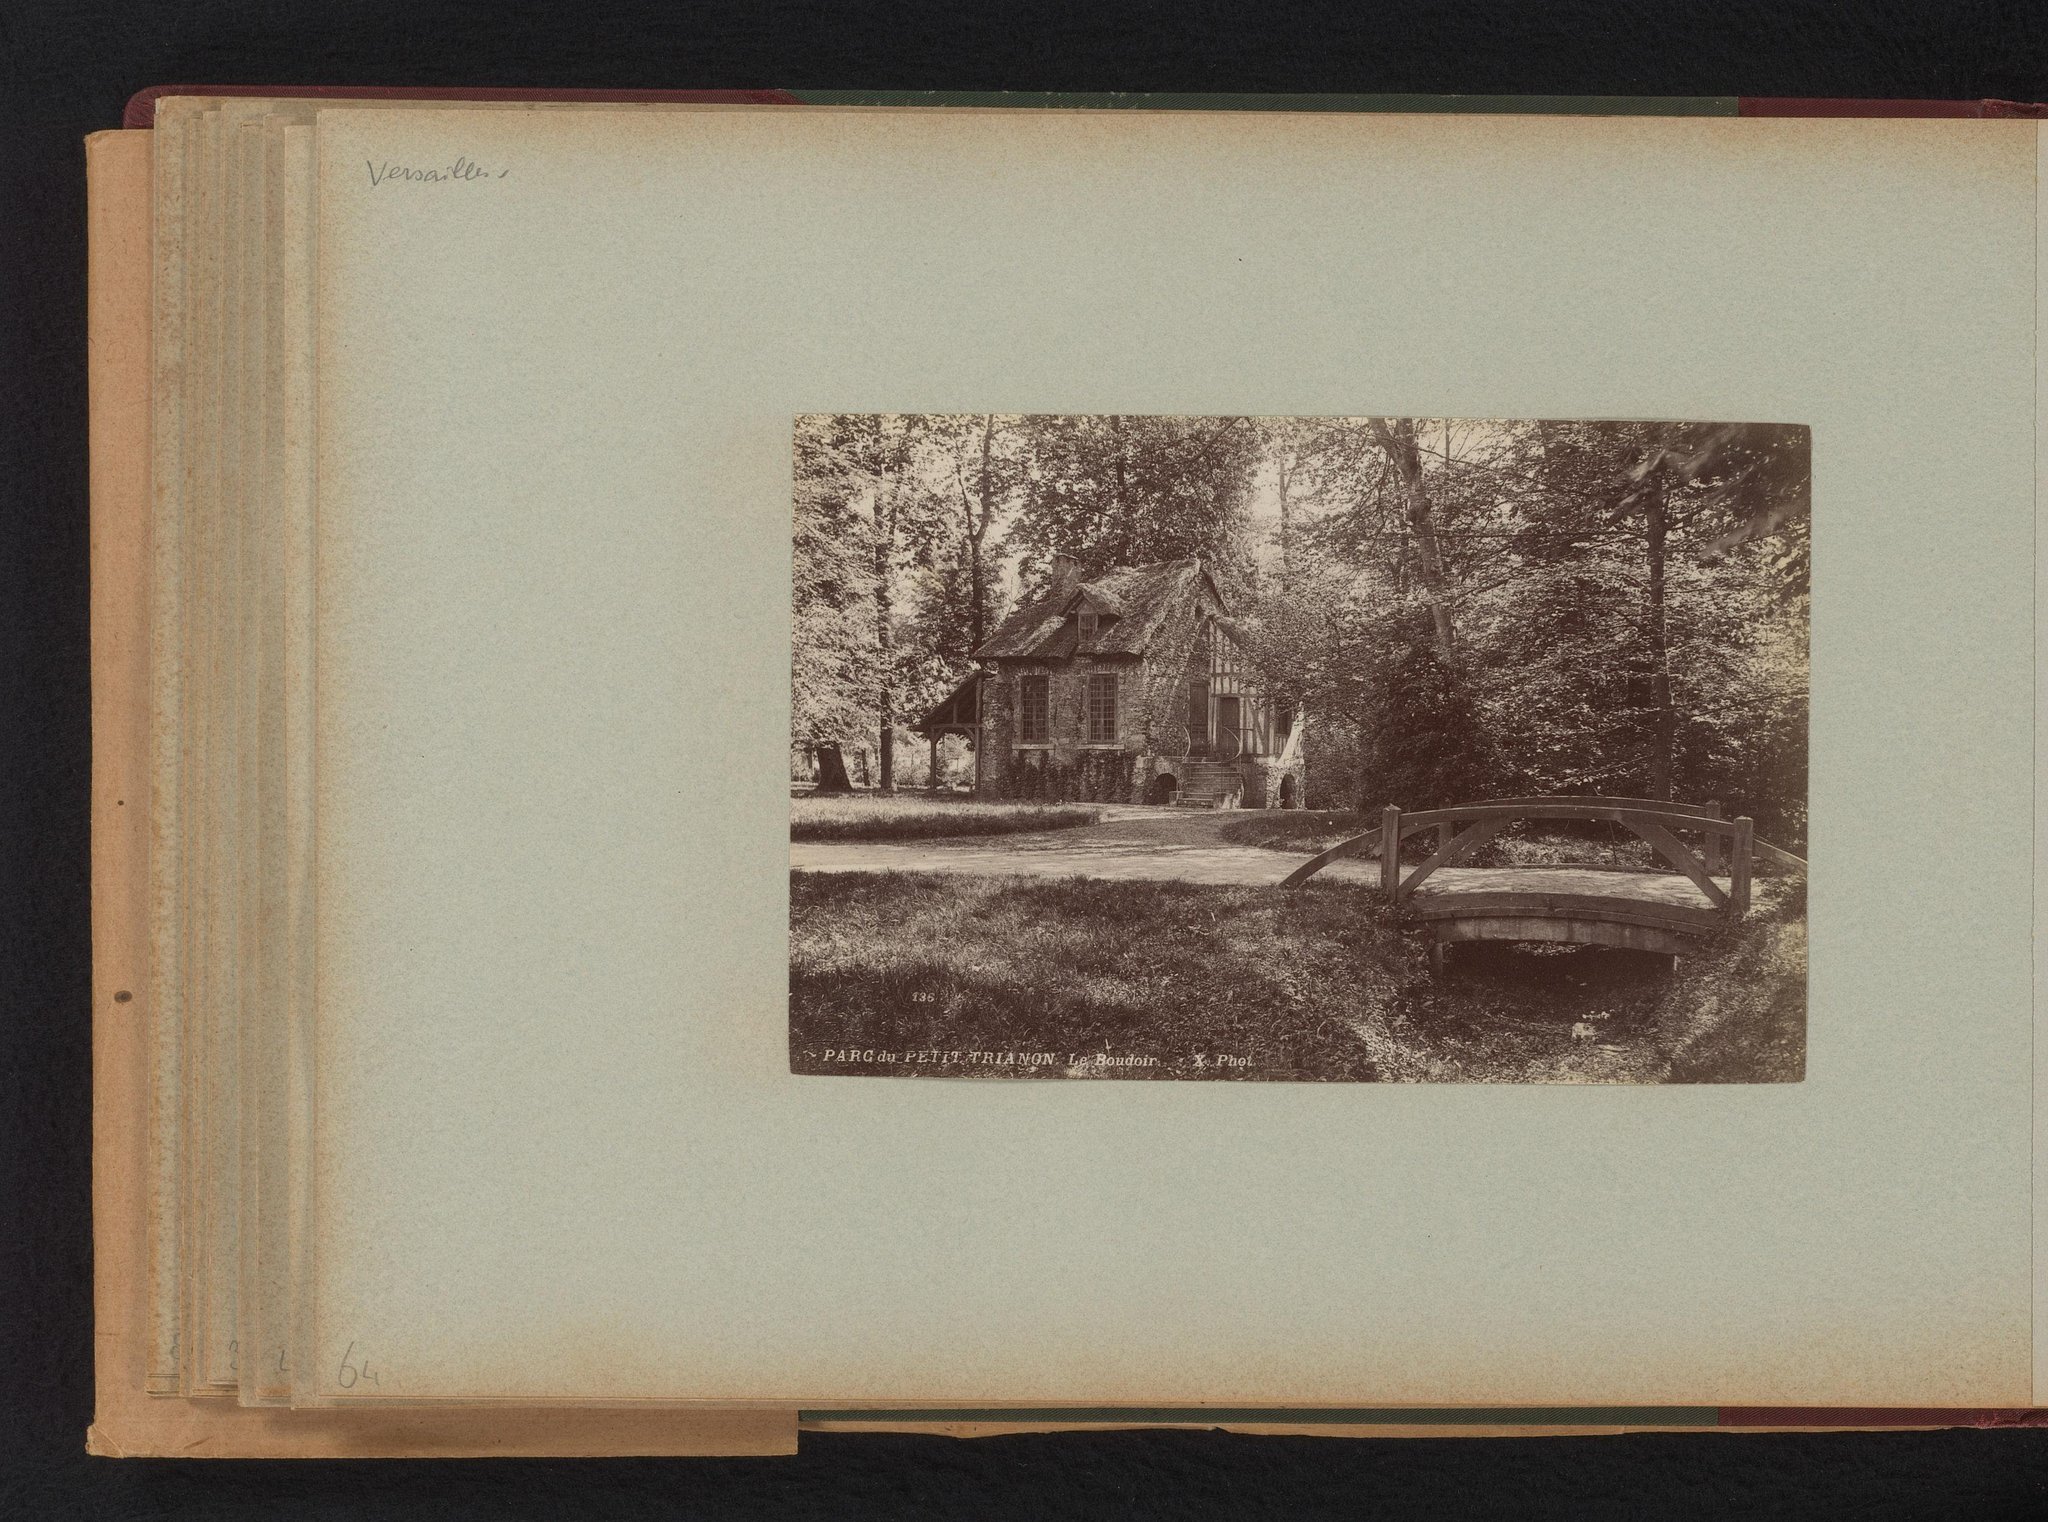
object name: photograph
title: Petit Trianon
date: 1887-1900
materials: paper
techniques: albumen print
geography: versailles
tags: forest, wood, exterior ~ representation of a building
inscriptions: inscription: ‘Versailles’, number: ‘136’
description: Tussen 1887 en ca. 1900 werkten Neurdein frères onder andere onder de naam 'X phot.'.